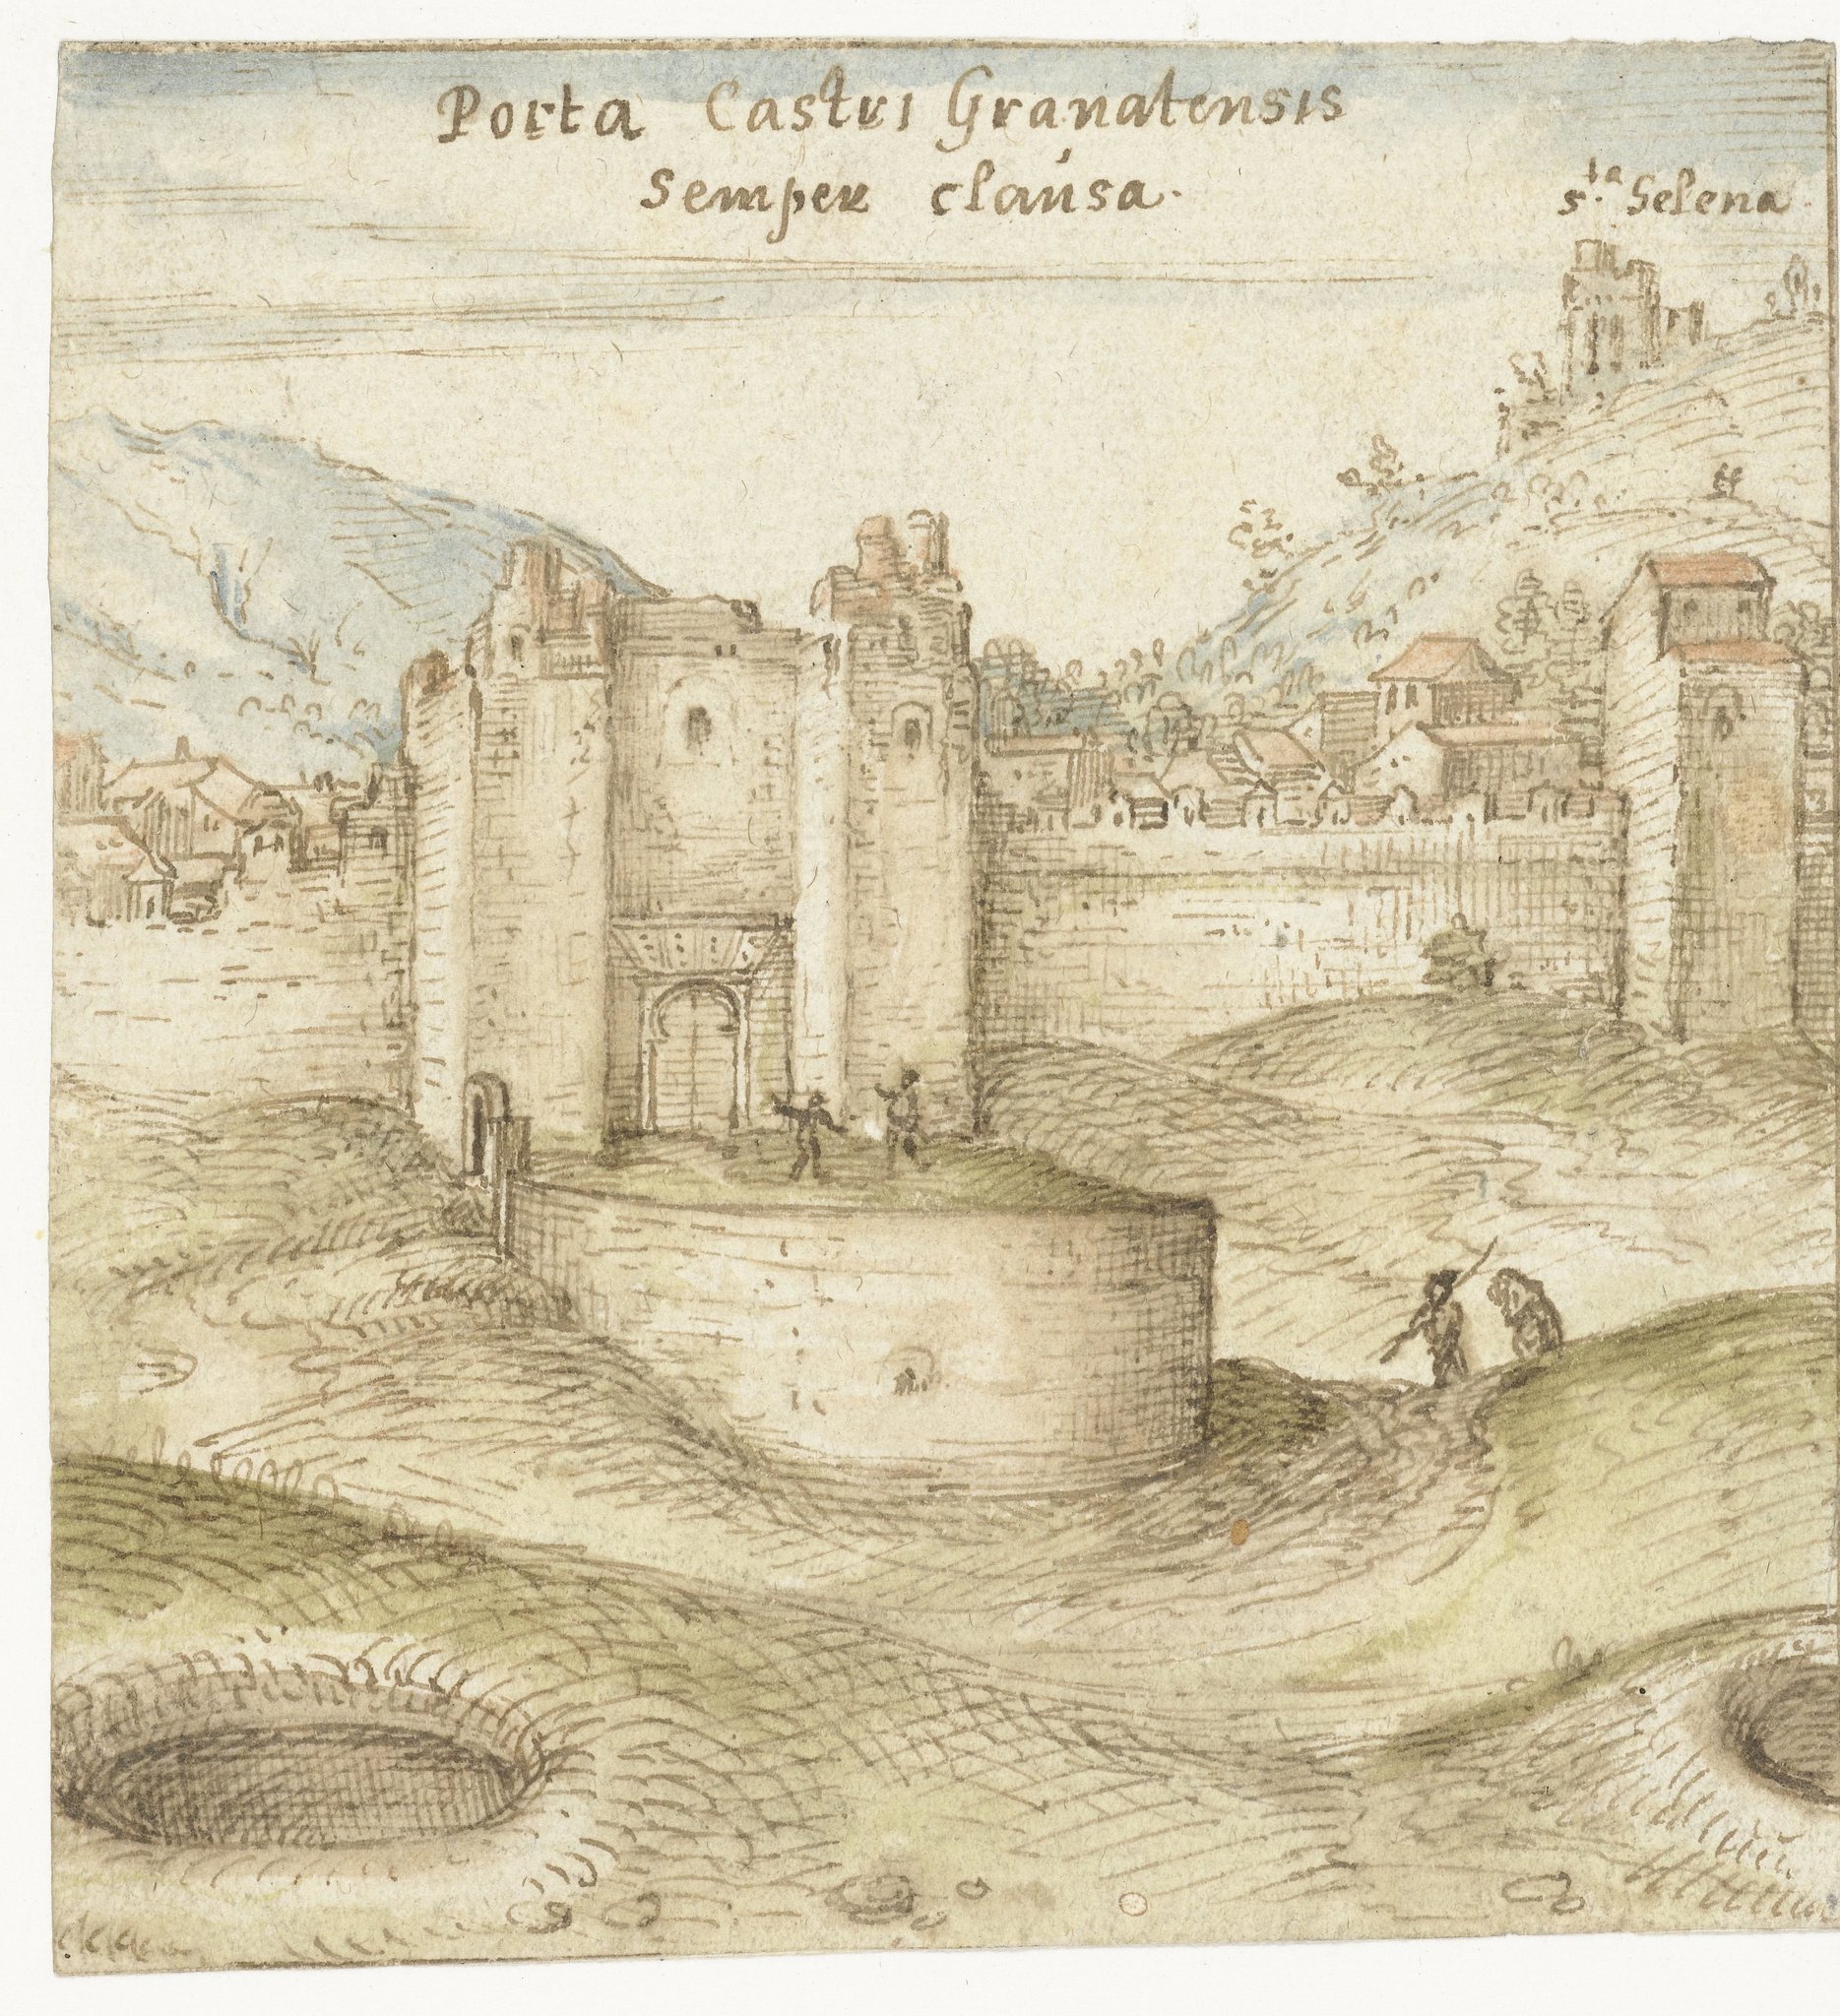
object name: drawing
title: Gesloten poort tot het kasteel (Alhambra) te Granada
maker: joris hoefnagel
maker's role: draughtsman, painter, print maker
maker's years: 1542-1600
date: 1561-1601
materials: ink, paper, watercolor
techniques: brush, pen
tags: gate ~ fortified city, castle, city-gate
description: De tekening is waarschijnlijk gebruikt voor Braun-Hogenberg dl. 5, pl. 14.